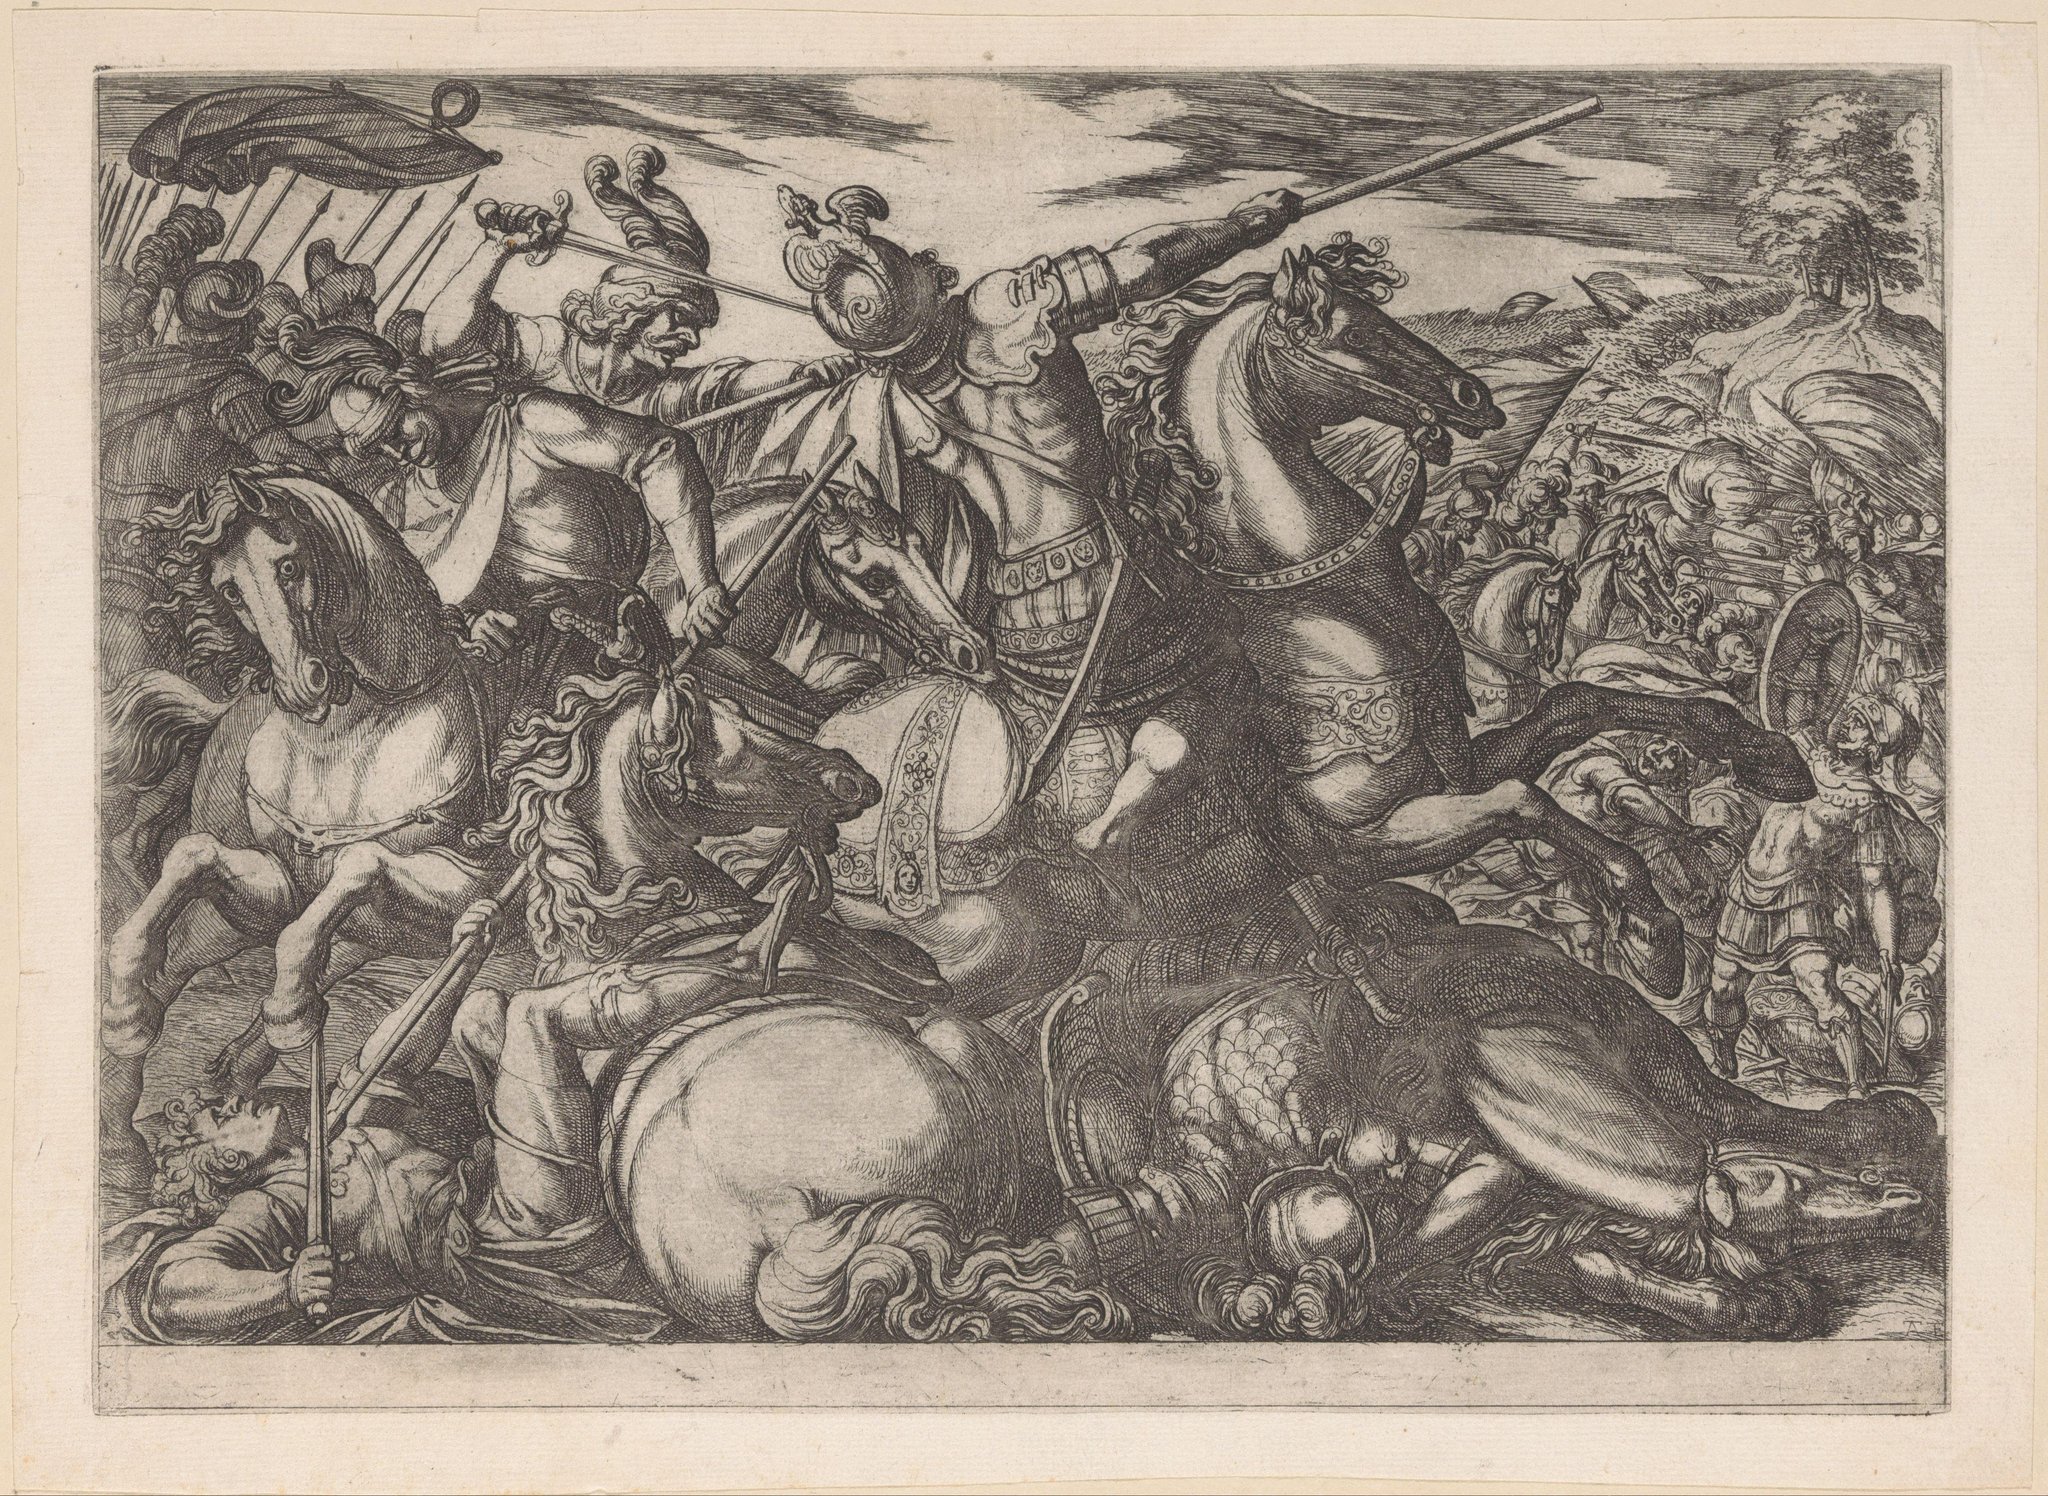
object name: print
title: Cavalerie gevecht dicht opeen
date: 1601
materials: paper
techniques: etching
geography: rome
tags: battle, warfare; military affairs (+ cavalry, horsemen), the soldier; the soldier's life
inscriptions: collector's mark: Lugt 240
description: Deze prent maakt deel uit van een reeks van acht prenten (+ titelprent).